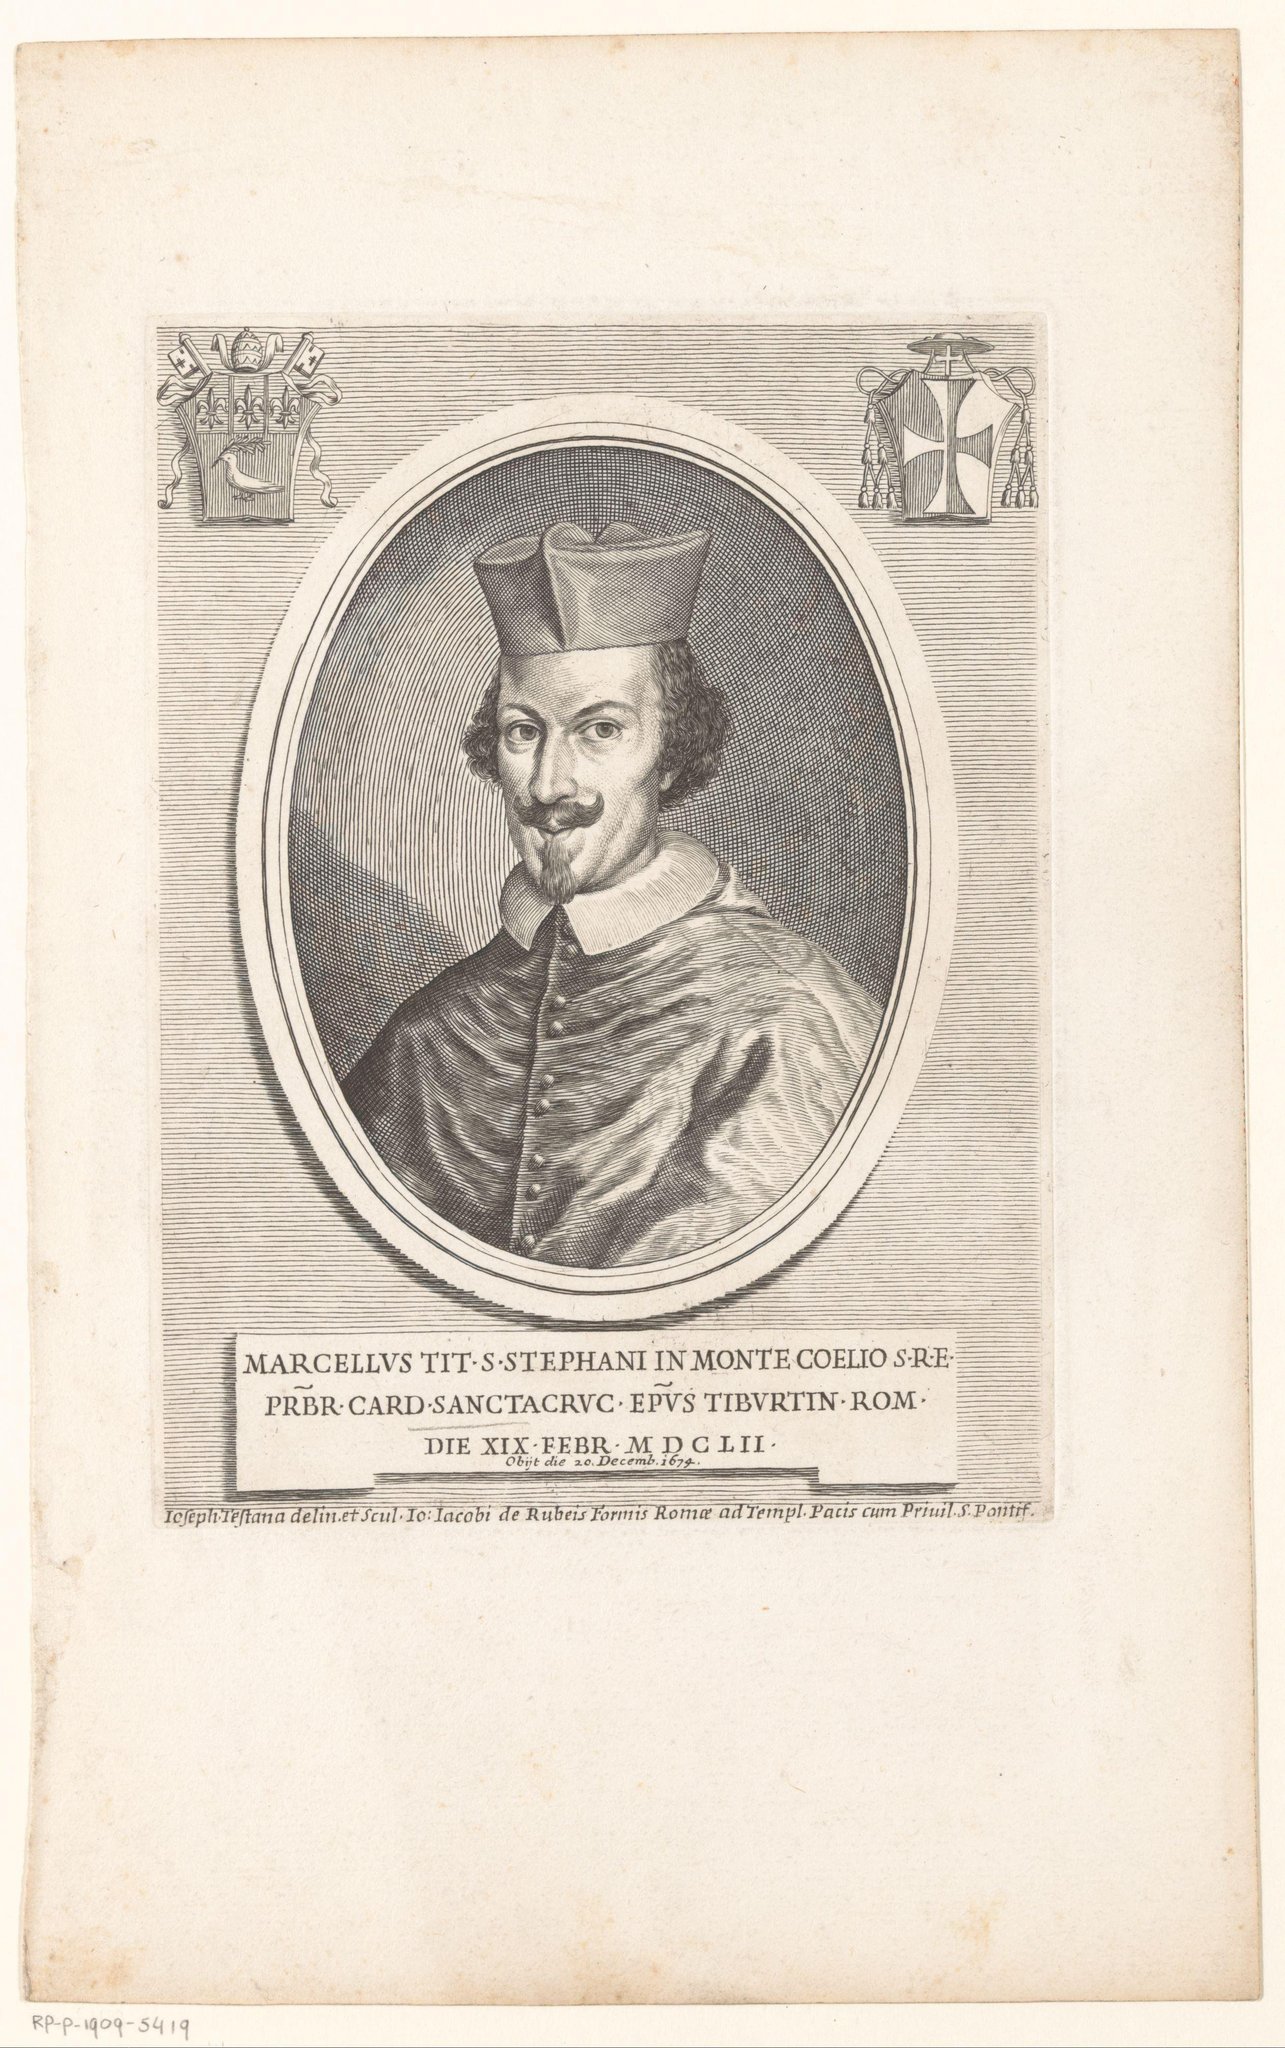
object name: print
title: Portret van kardinaal Marcello Santacroce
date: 1658-1679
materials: paper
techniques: engraving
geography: rome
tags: cardinal, historical persons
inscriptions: collector's mark: Lugt 2228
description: Prent uit een reeks van onbekende omvang met portretten van kardinalen. De prenten werden vanaf 1657 vervaardigd in opdracht van uitgever Giovanni Giacomo de’ Rossi, waarna de productie werd voortgezet onder leiding van zijn opvolgers Domenico de’ Rossi en Lorenzo Filippo de’ Rossi, en ten slotte onder leiding van de Calcographia R.C.A.